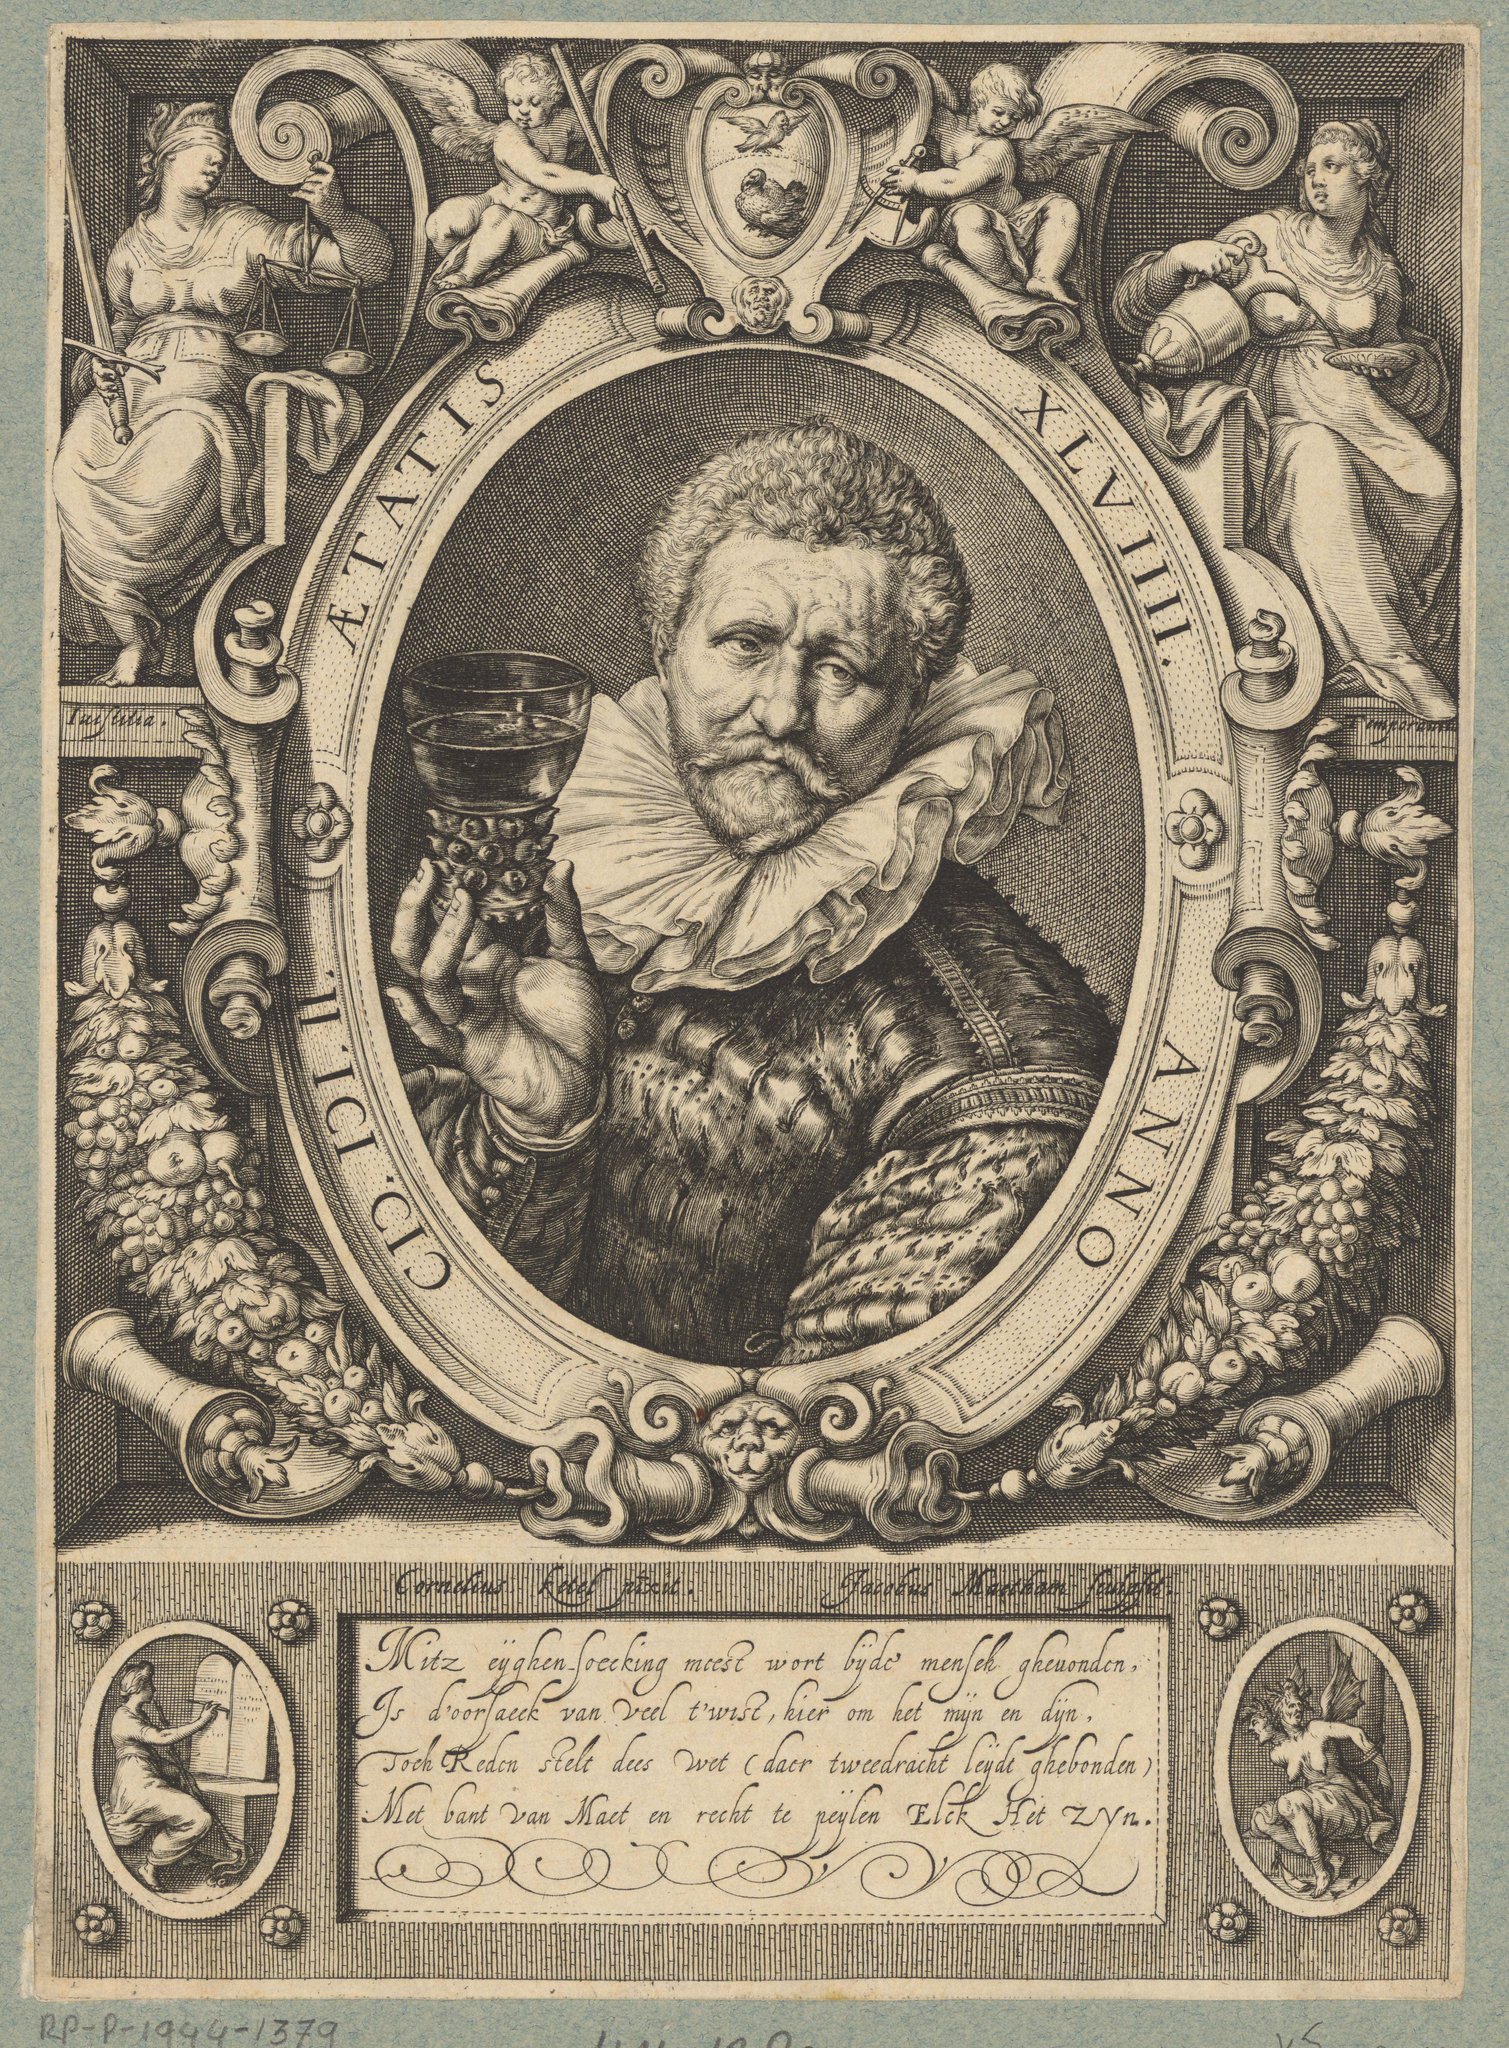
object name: print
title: Portret van Vincent Jacobsz. Coster op 49-jarige leeftijd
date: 1602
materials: paper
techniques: engraving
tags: temperance, 'temperantia'; 'temperanza' (ripa) ~ one of the four cardinal virtues, justice, 'justitia'; 'giustitia divina' (ripa) ~ one of the four cardinal virtues, historical persons, wine-testing, wine-grading, armorial bearing, heraldry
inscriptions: collector's mark: Lugt 2228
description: Met zijn rechterhand heft hij een wijnglas.